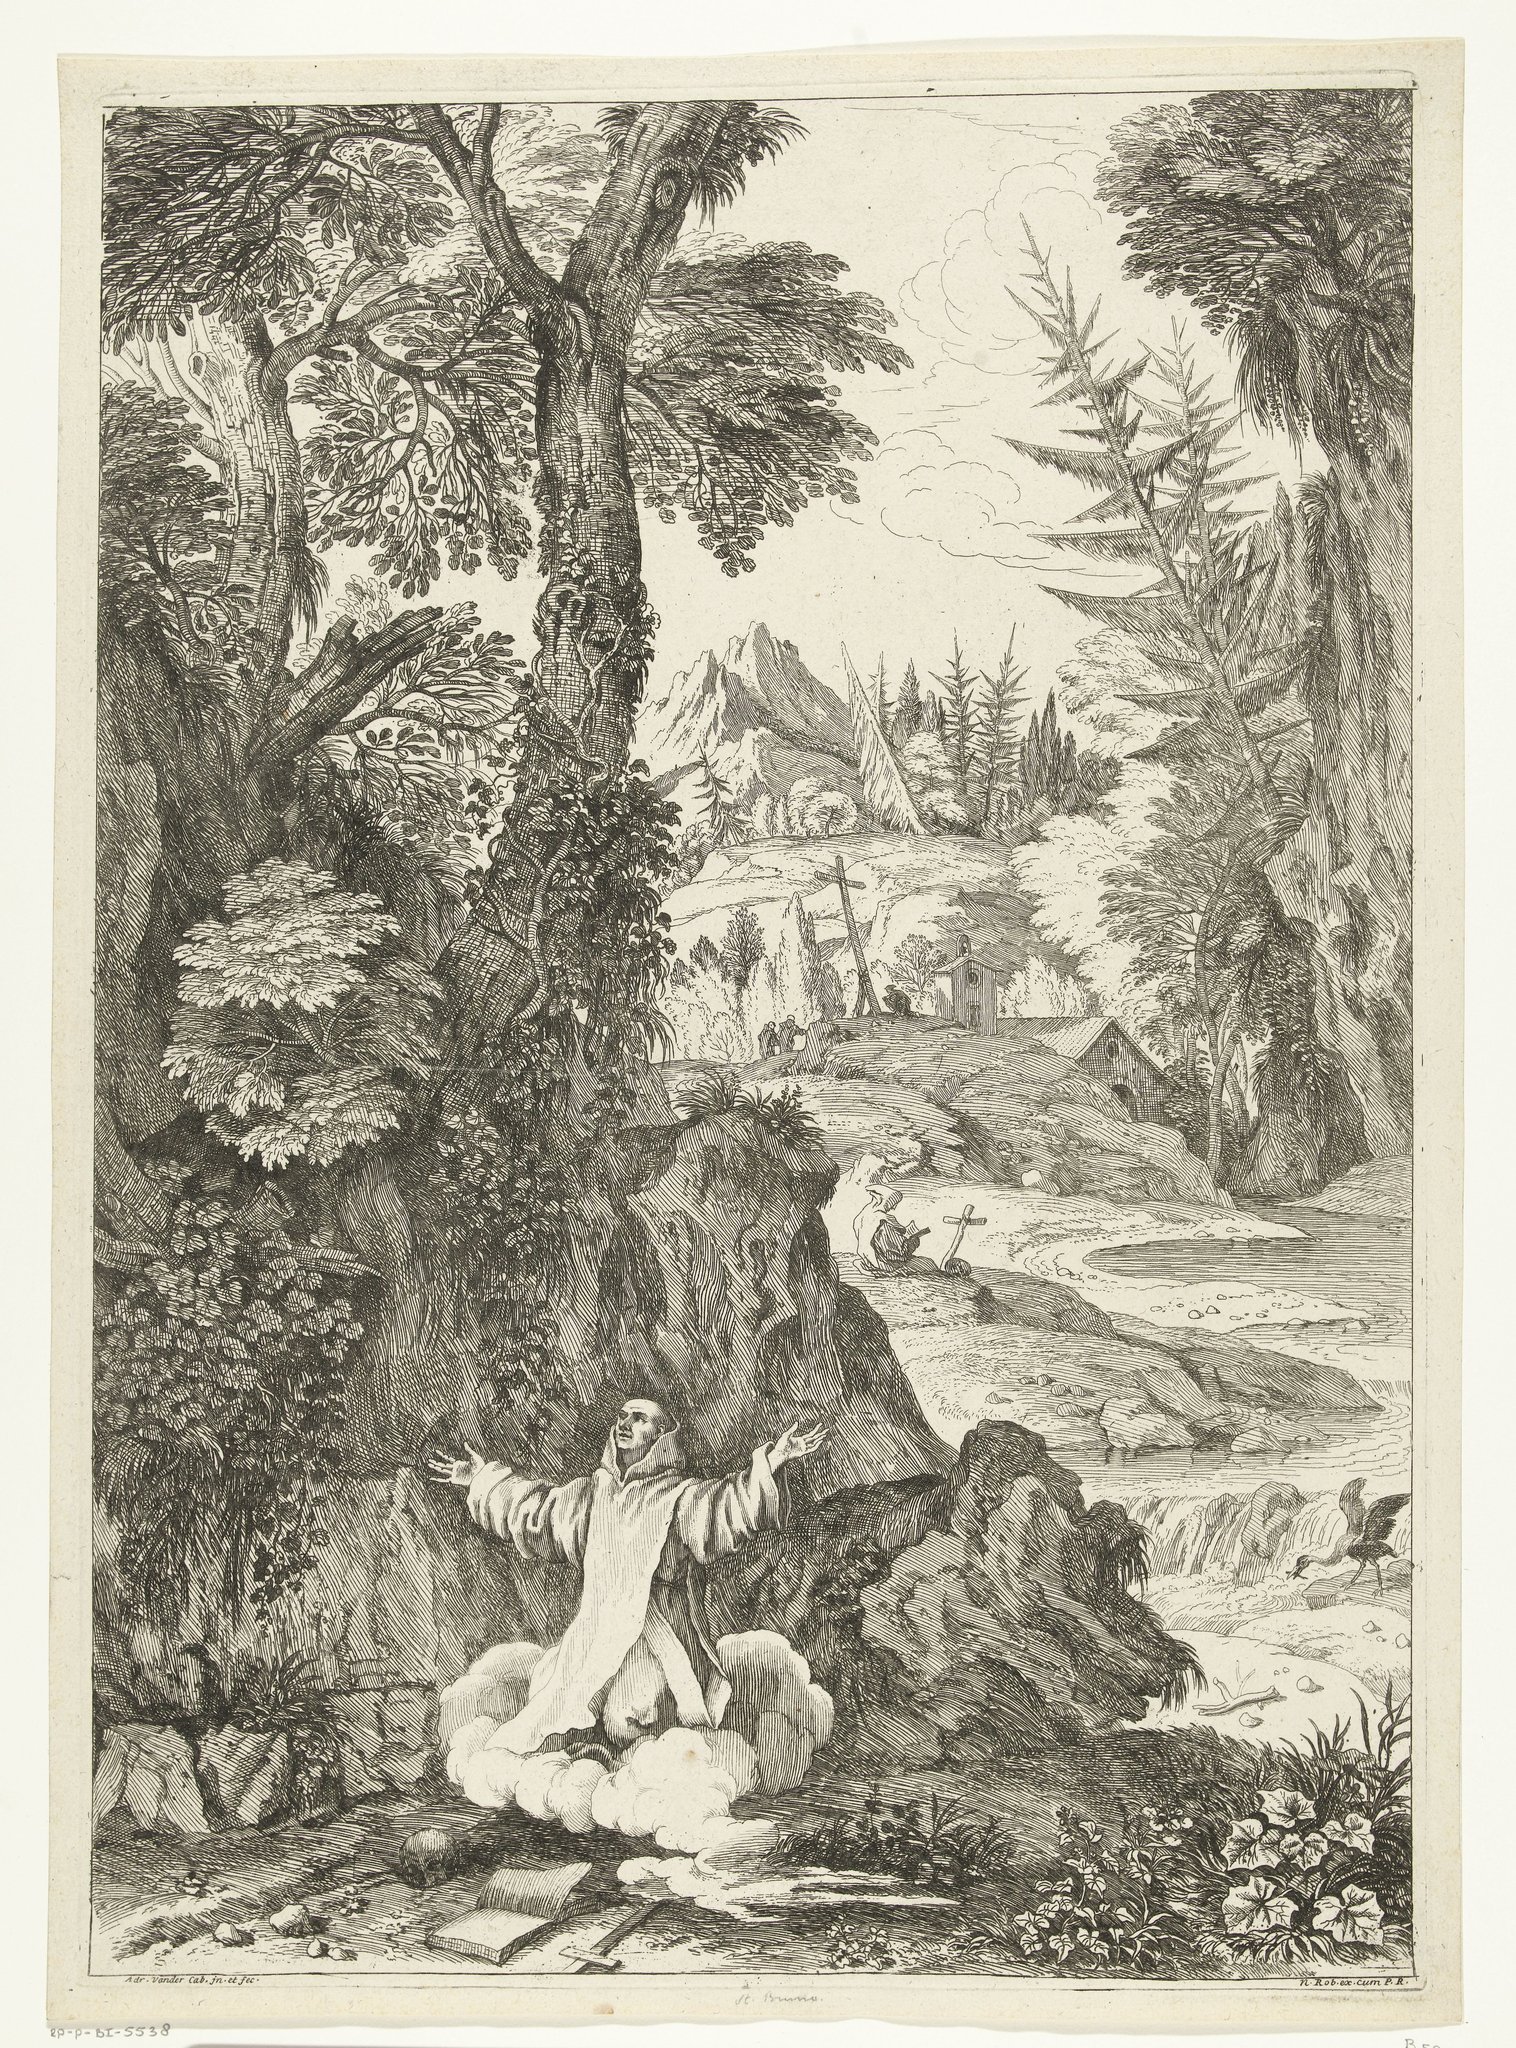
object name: print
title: Heilige Bruno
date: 1648-1705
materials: paper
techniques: etching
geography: france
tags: the founder of the order of the carthusians, bruno; possible attributes: cross, finger at lips, lily, mitre at his feet, olive-branch, ray of light, skull, (seven) star(s)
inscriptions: collector's mark: Lugt 240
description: Berglandschap met de heilige Bruno, in monnikshabijt, geknield en de armen gespreid, zittend op een wolk. Op de grond voor hem een schedel, crucifix en opengeslagen boek. Op de achtergrond, langs een rivier, een biddende monnik bij kruis, en op een heuvel, waarachter een gebouw, een groot kruis.